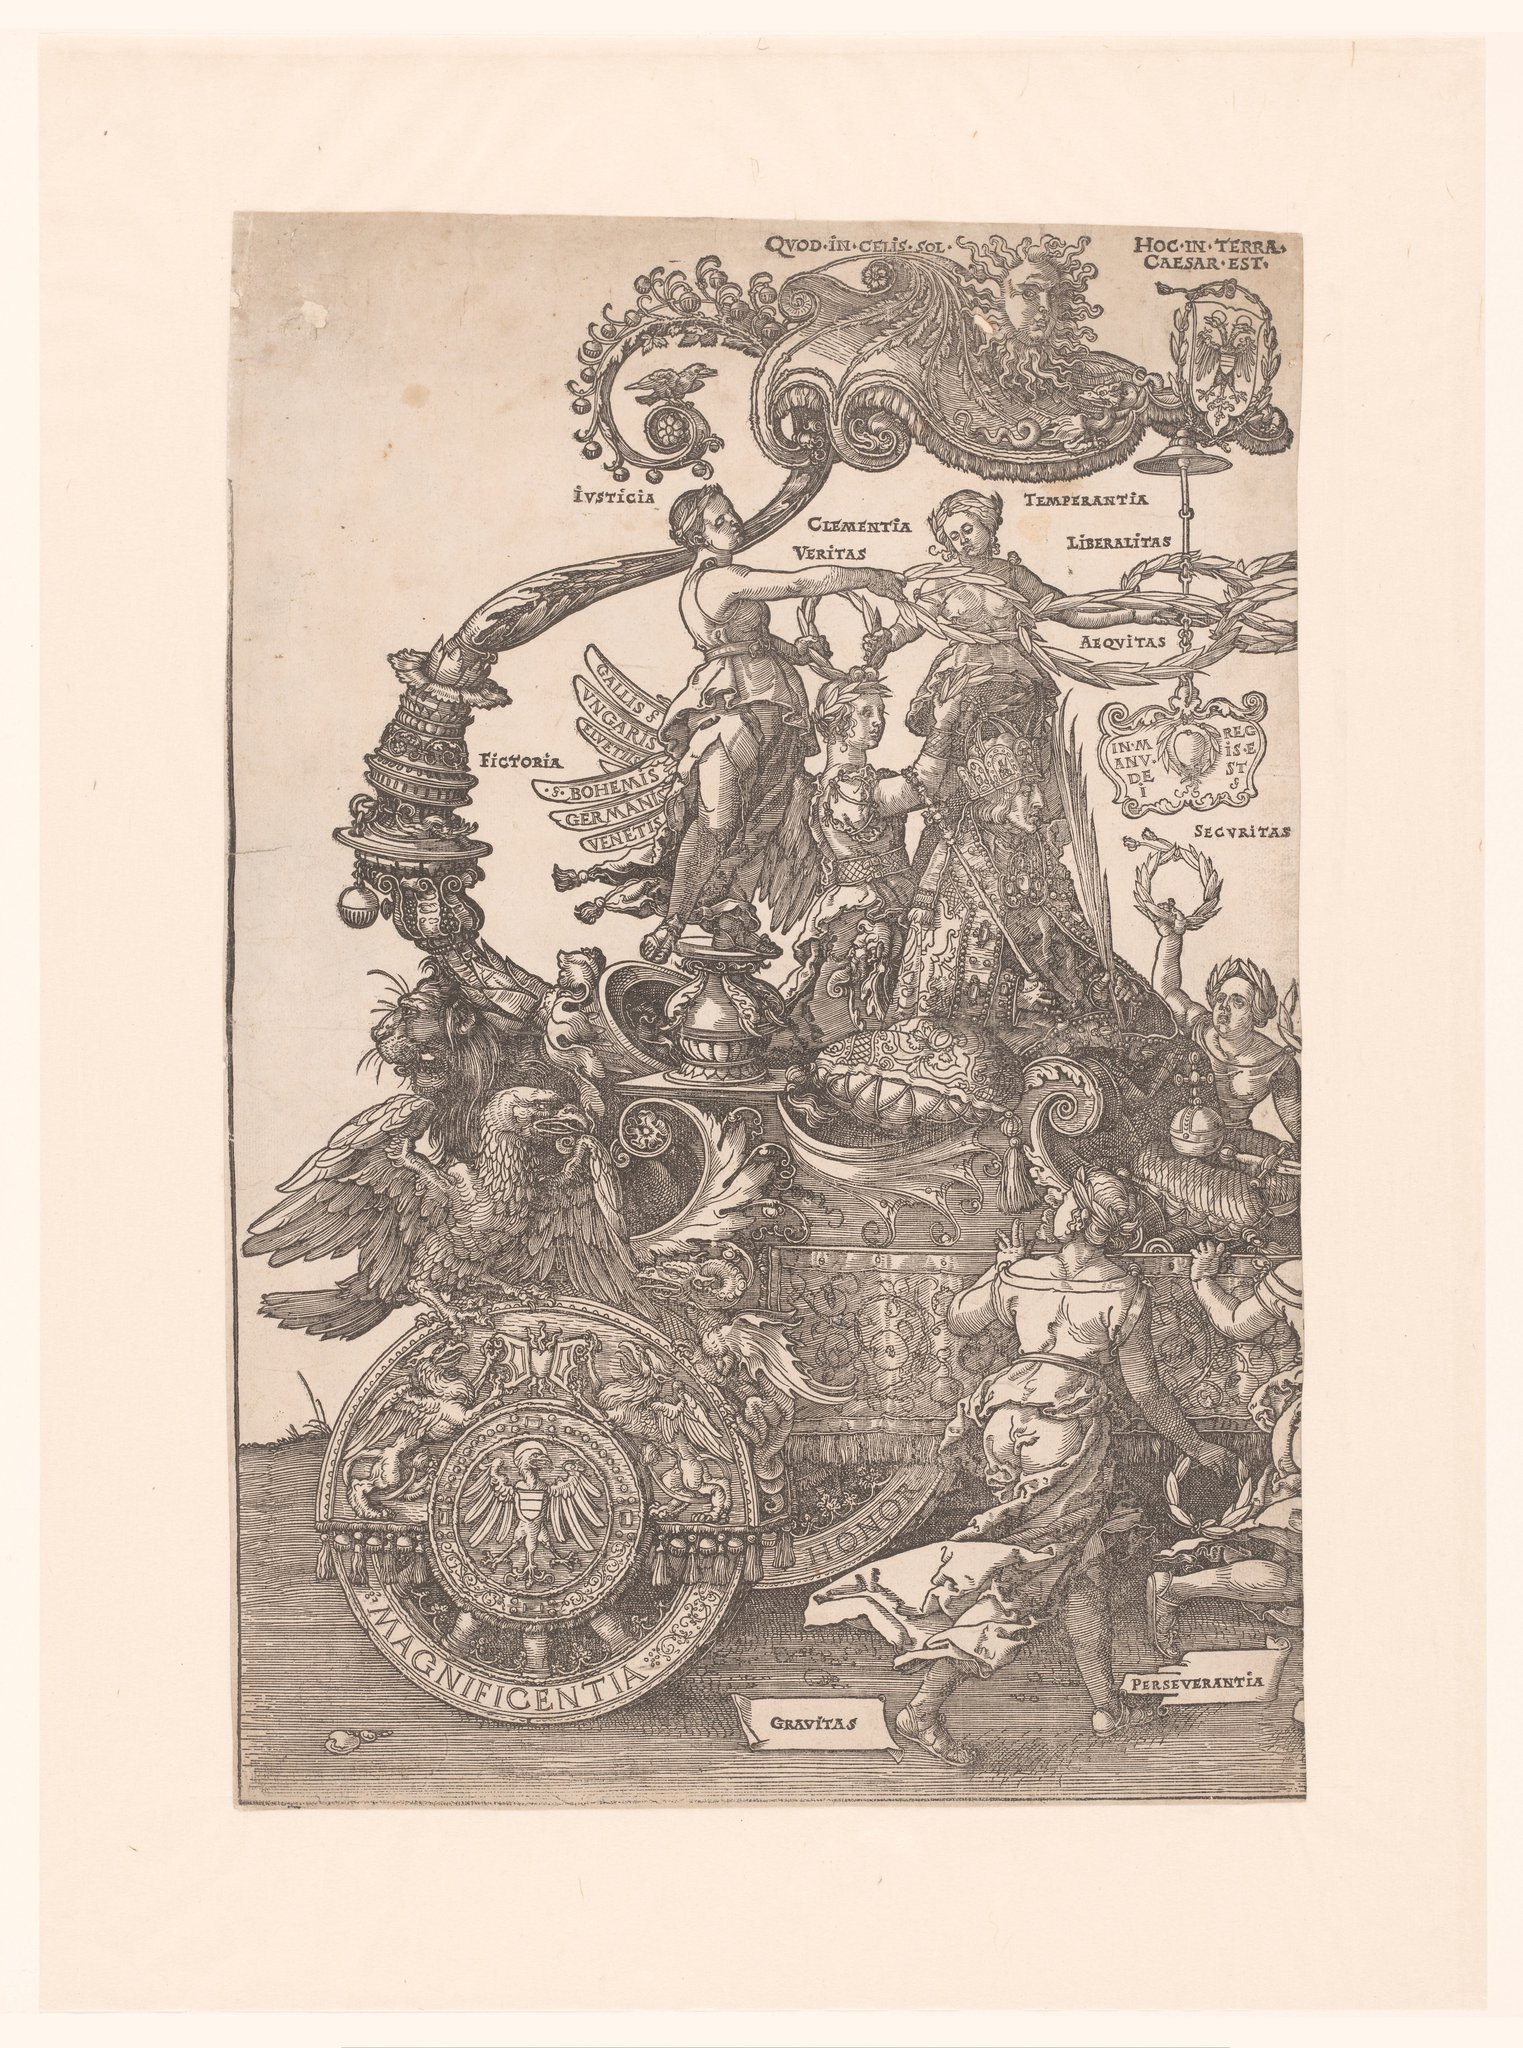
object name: print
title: Triomfwagen van keizer Maximiliaan I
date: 1527-1529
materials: paper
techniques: woodcut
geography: antwerp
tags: maximilian i (holy roman emperor), chariot, triumphal car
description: De grote triomfwagen ter ere van keizer Maximiliaan I bij zijn overlijden op 12 januari 1519. Eerste blad met het linkerdeel van de triomfwagen met keizer Maximiliaan die gekroond wordt door Victoria. De wagen begeleid door vrouwelijke personificaties van allerlei deugden.